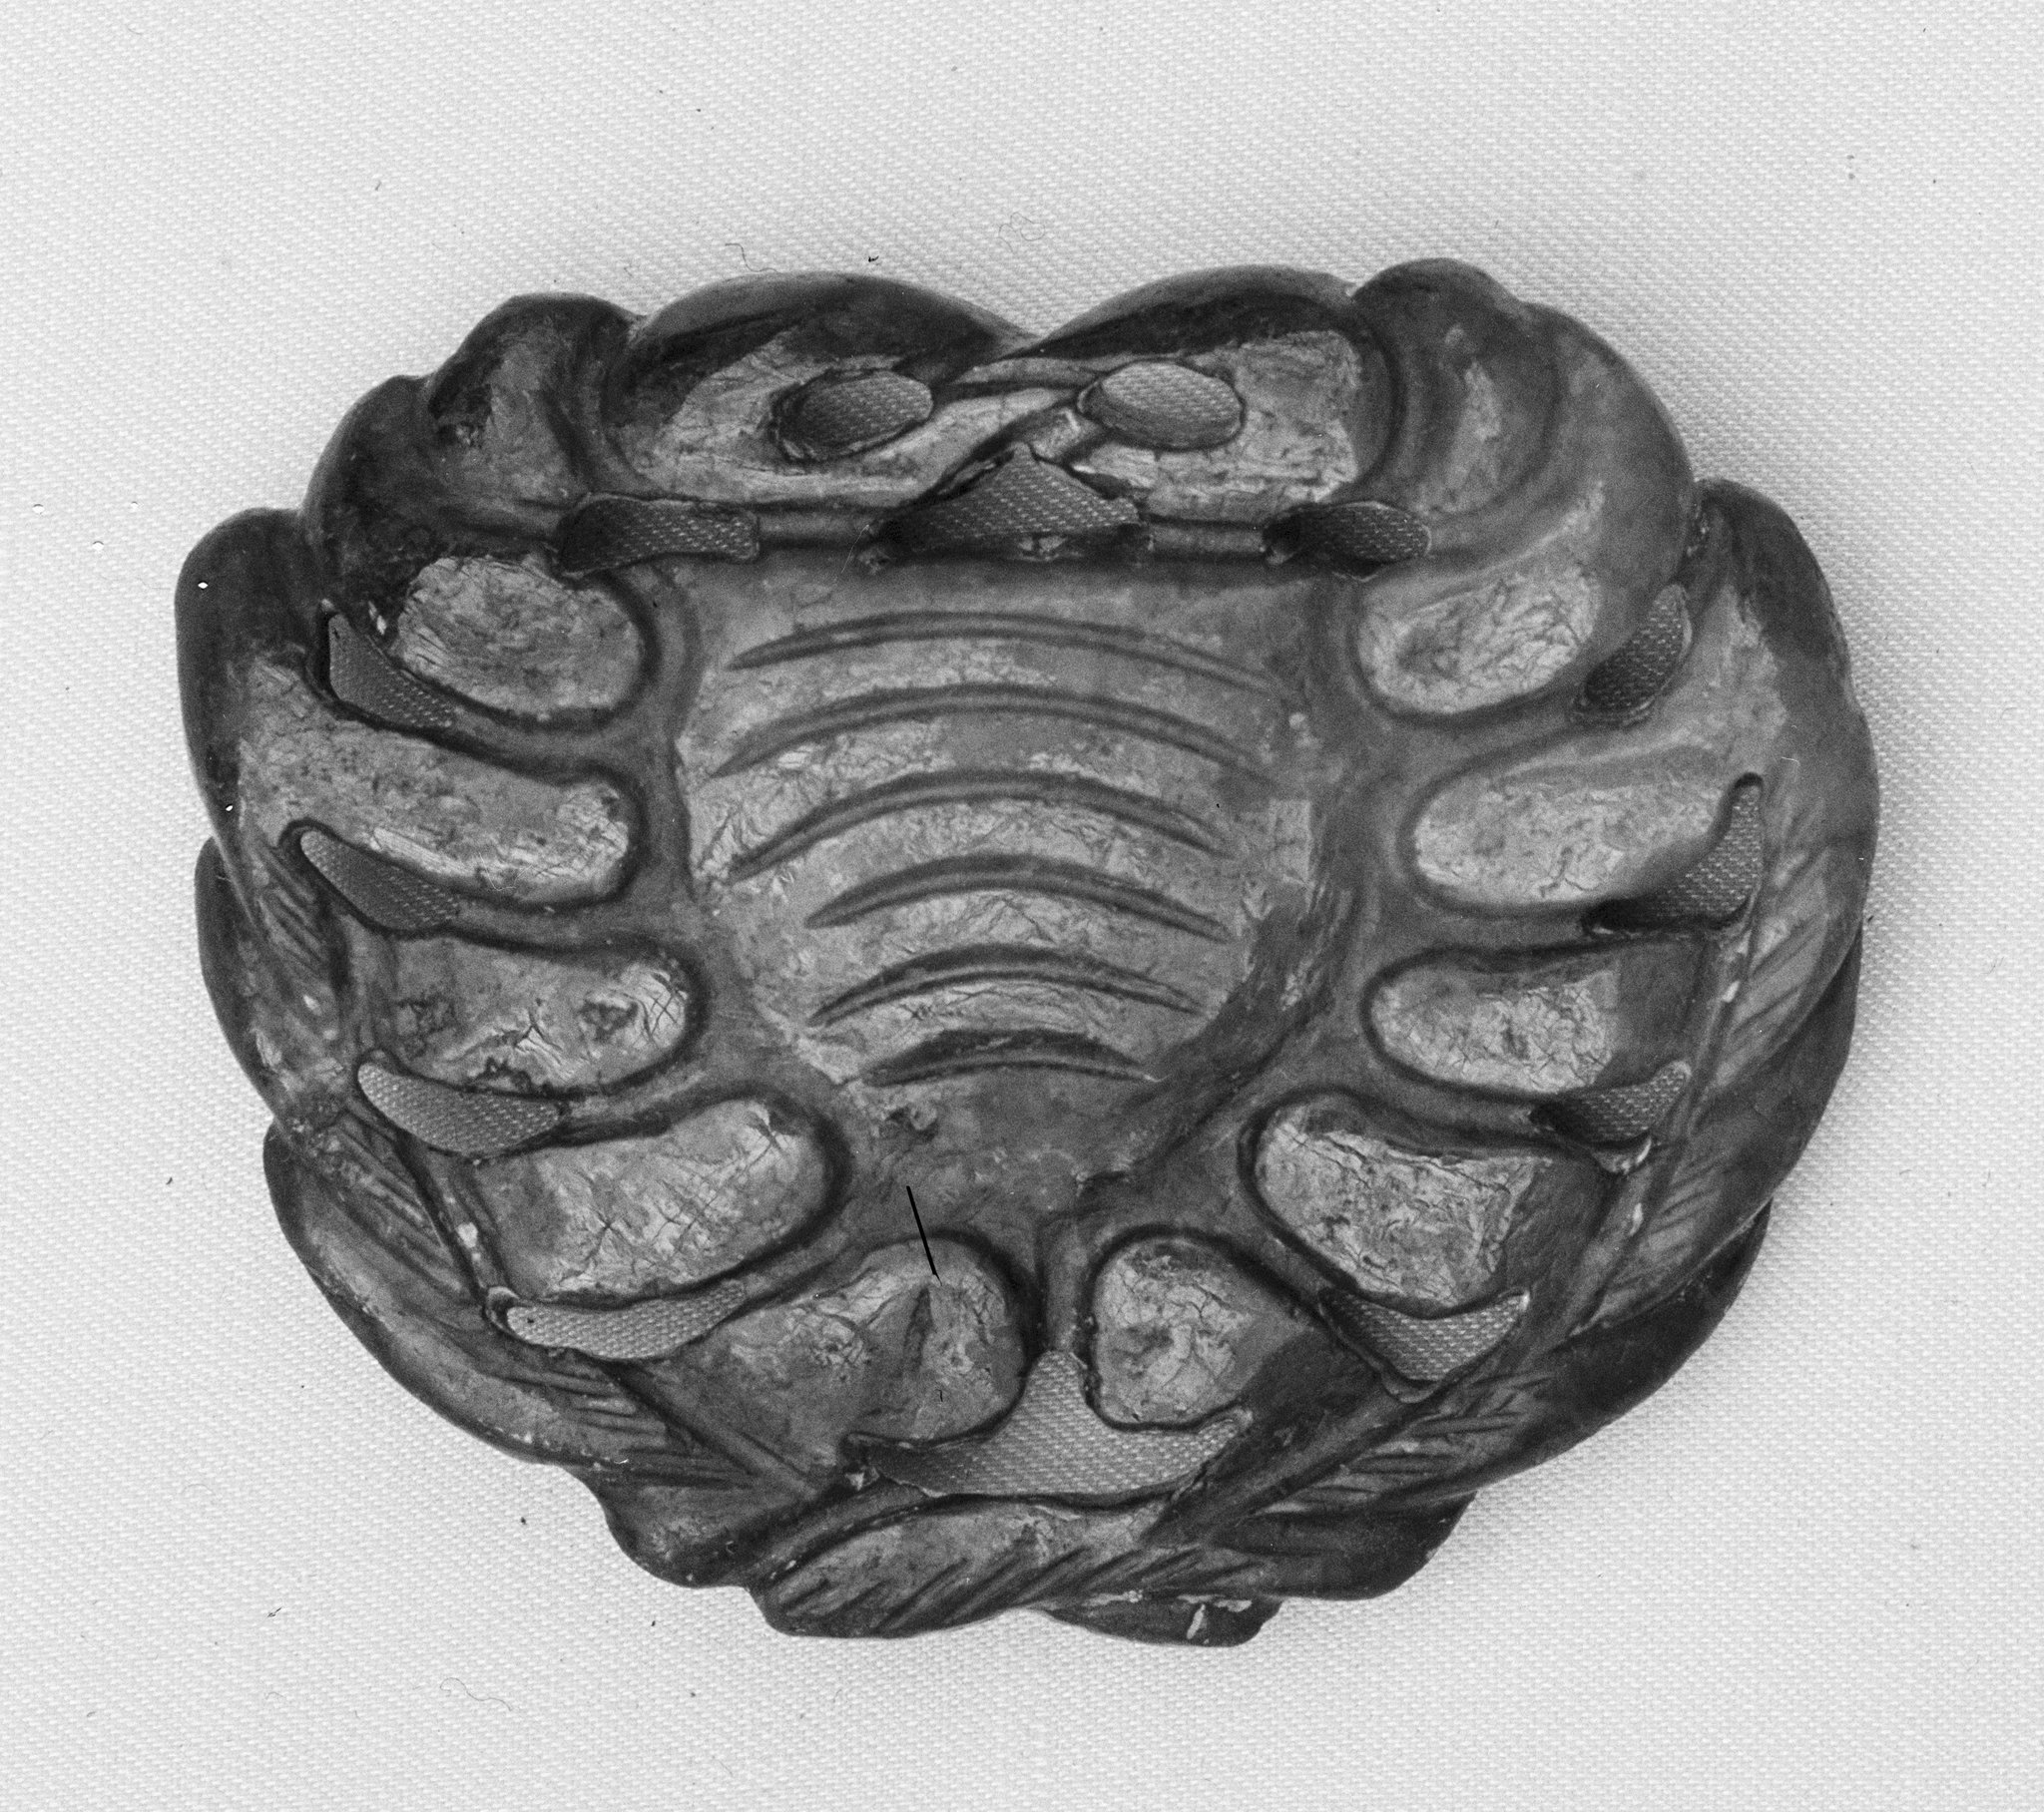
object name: button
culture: chinese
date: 1796-1820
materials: jade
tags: crabs